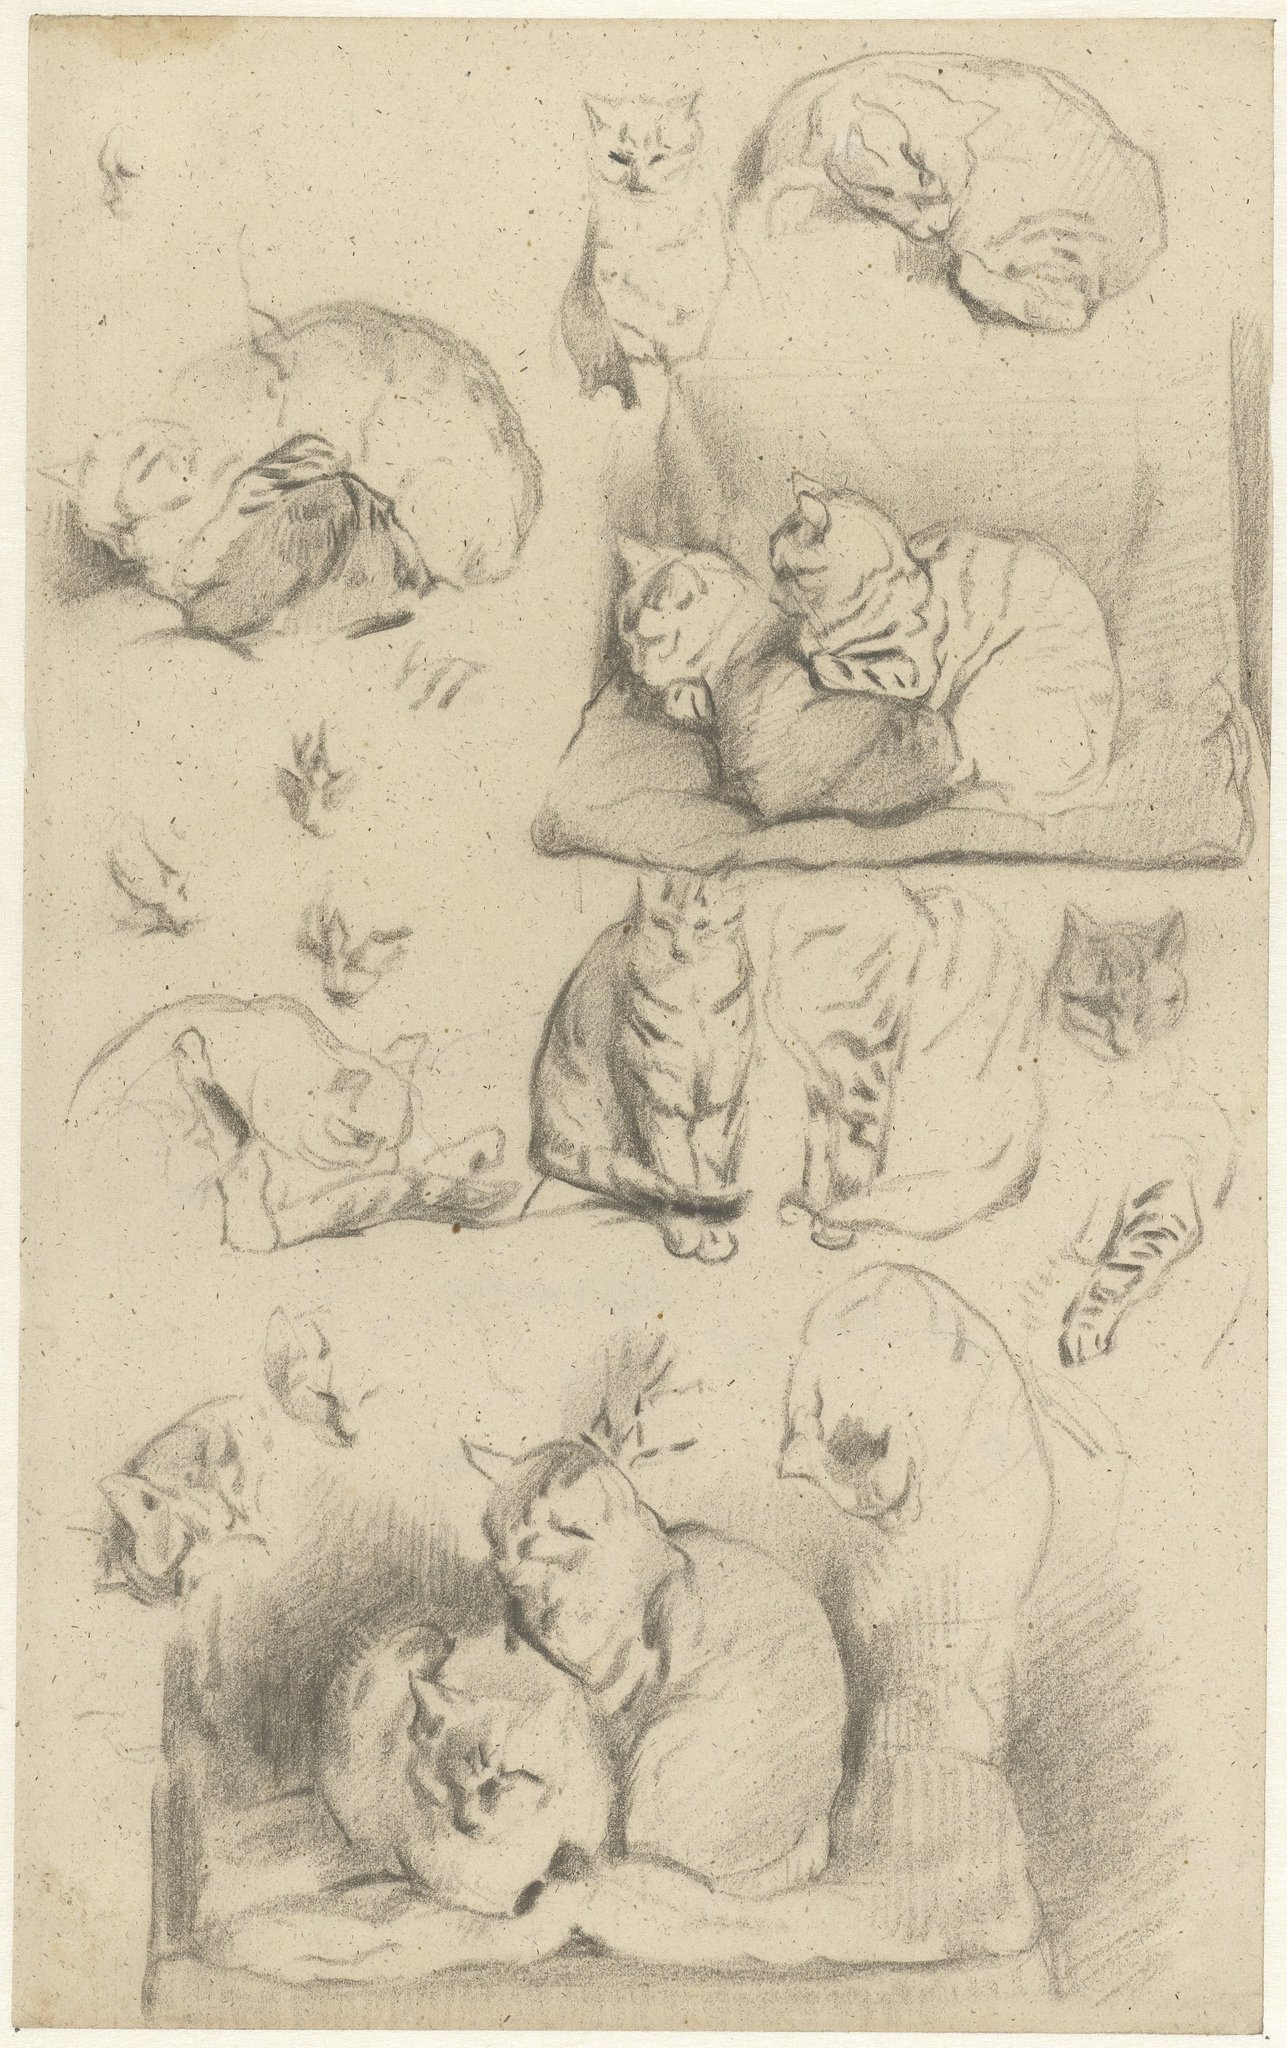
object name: drawing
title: Studies van katten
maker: guillaume anne van der brugghen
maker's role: draughtsman, print maker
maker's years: 1812-1891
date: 1821-1891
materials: charcoal, paper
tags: cat